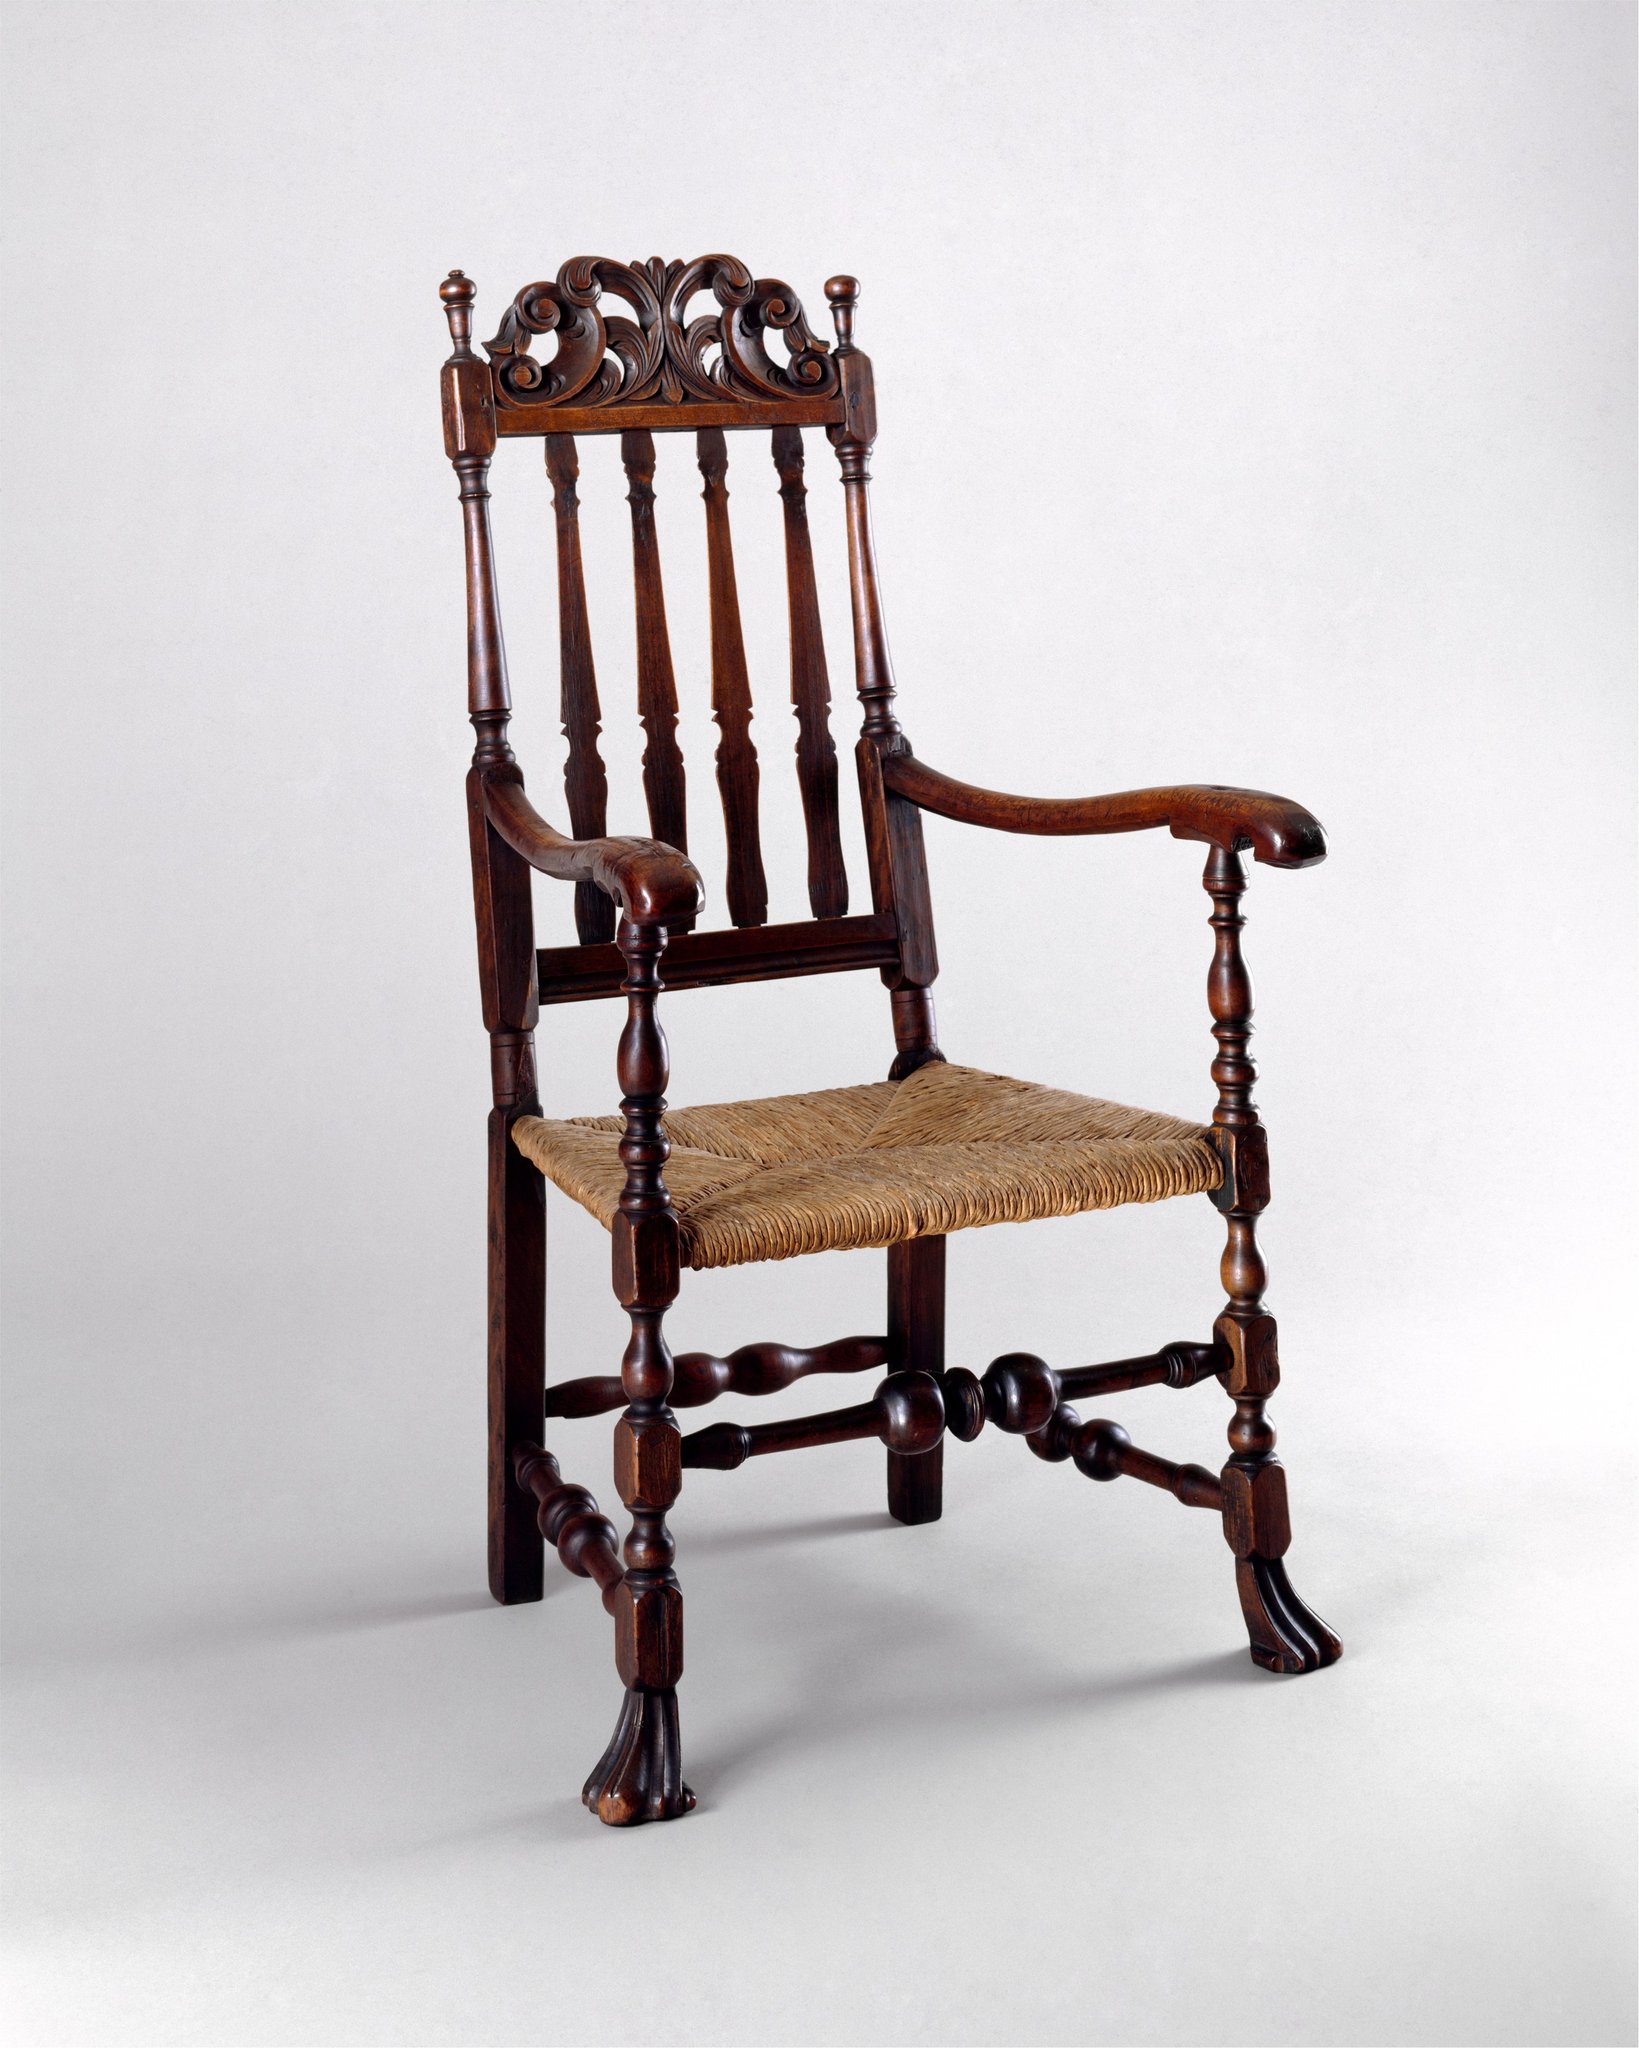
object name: banister back armchair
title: Banister-back armchair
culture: american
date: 1720-1740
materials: wood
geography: united states